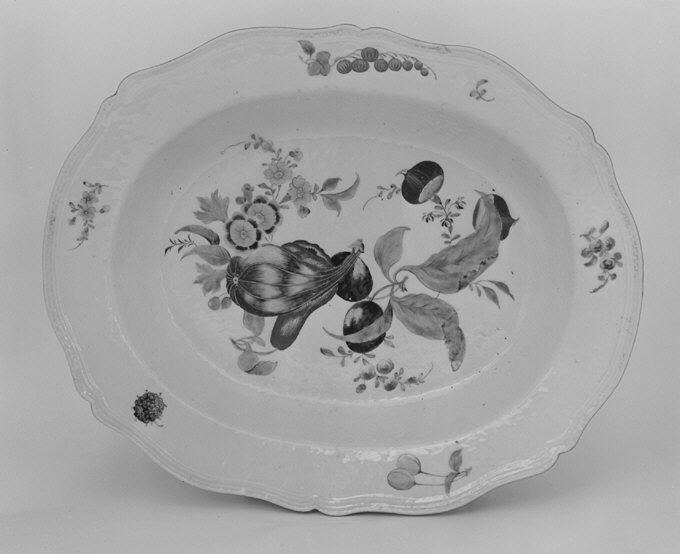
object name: platter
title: Platter (part of a service)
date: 1760-1770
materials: hard paste porcelain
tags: fruit,vegetables,flowers